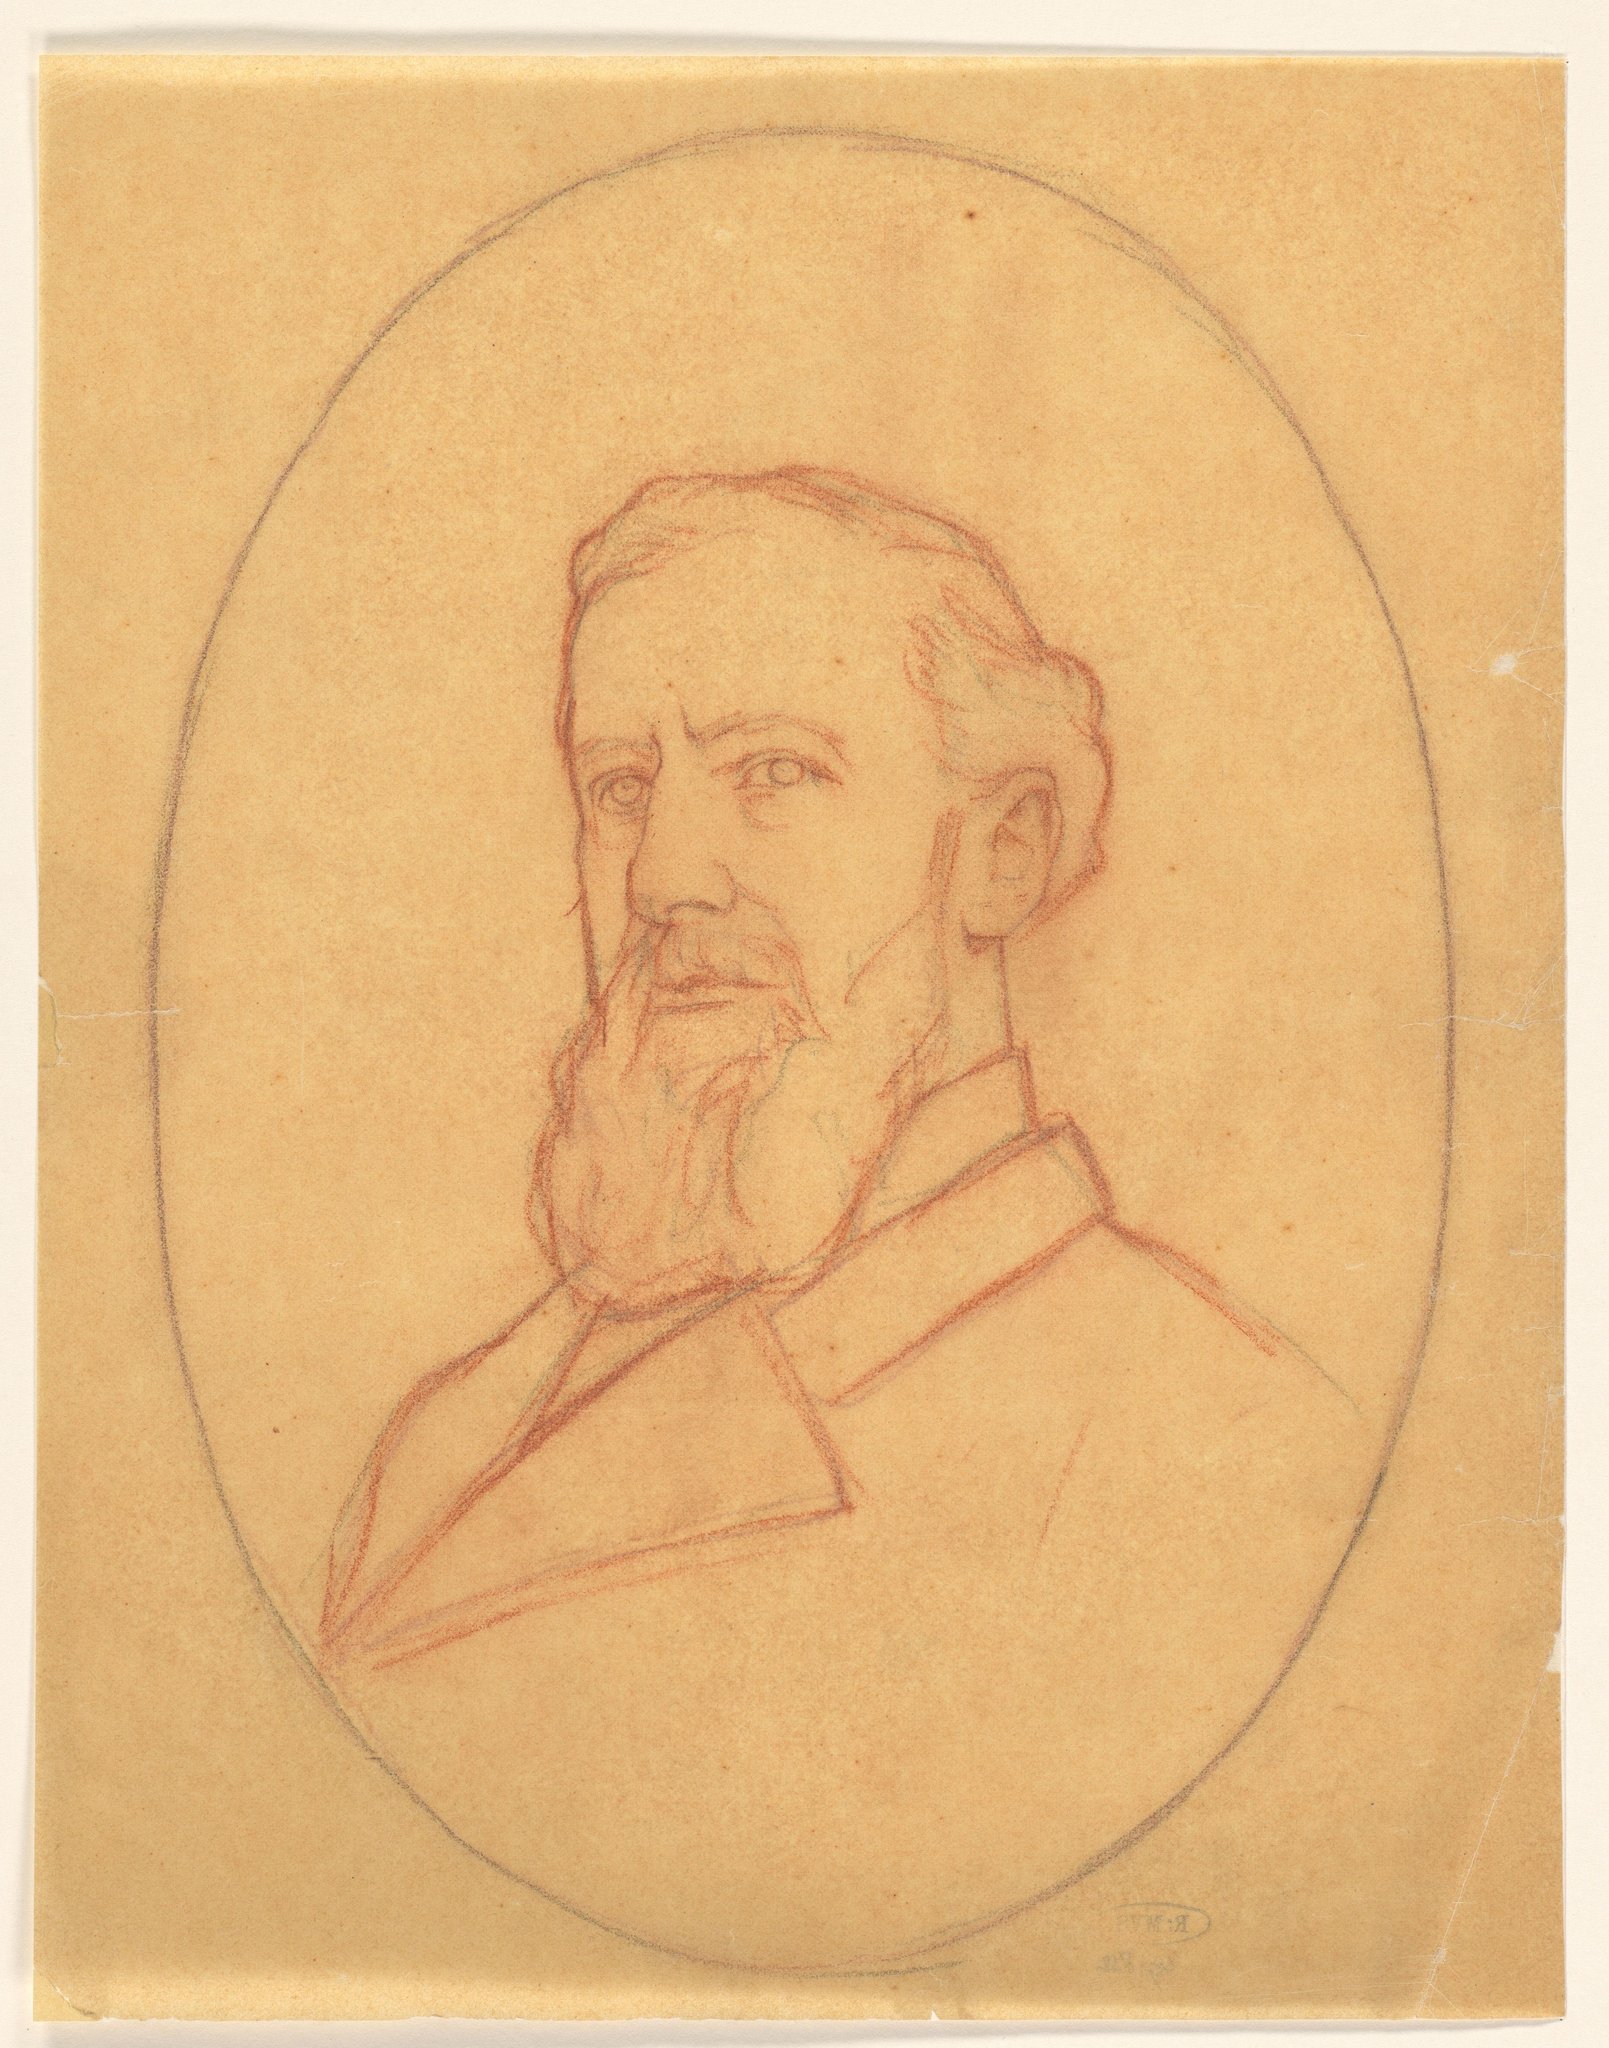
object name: drawing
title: Portret van een bebaarde man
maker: august allebé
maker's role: draughtsman, print maker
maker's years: 1838-1927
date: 1848-1927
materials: chalk, paper